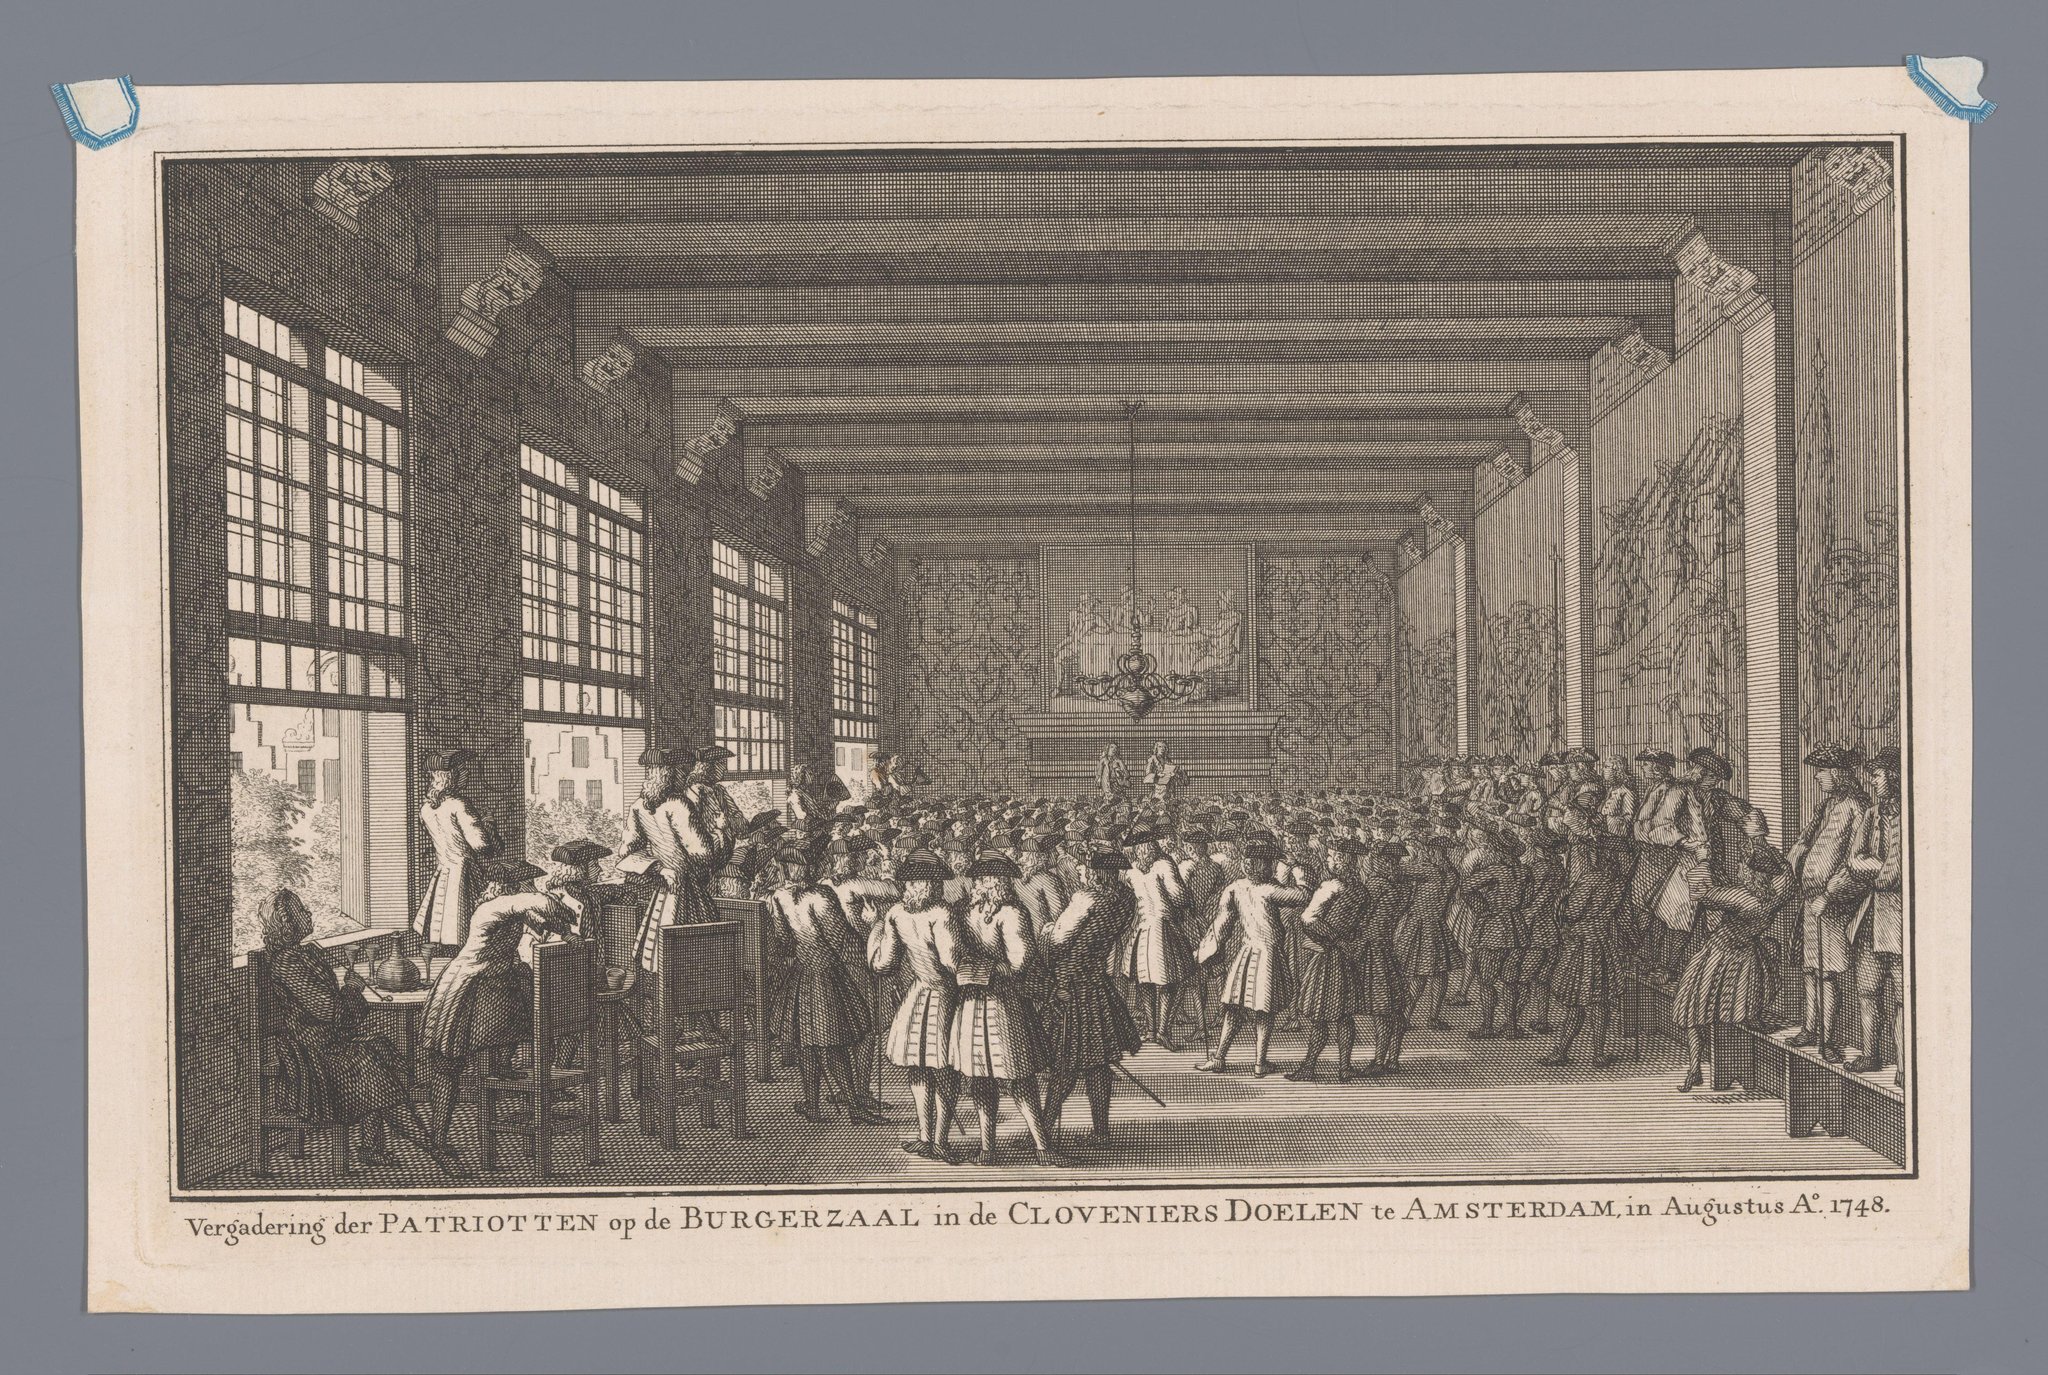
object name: print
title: Bijeenkomst van de Doelisten in de Kloveniersdoelen, 1748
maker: Anonymous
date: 1748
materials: paper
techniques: engraving, etching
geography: northern netherlands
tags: meeting, assembly, political meeting, propaganda meeting